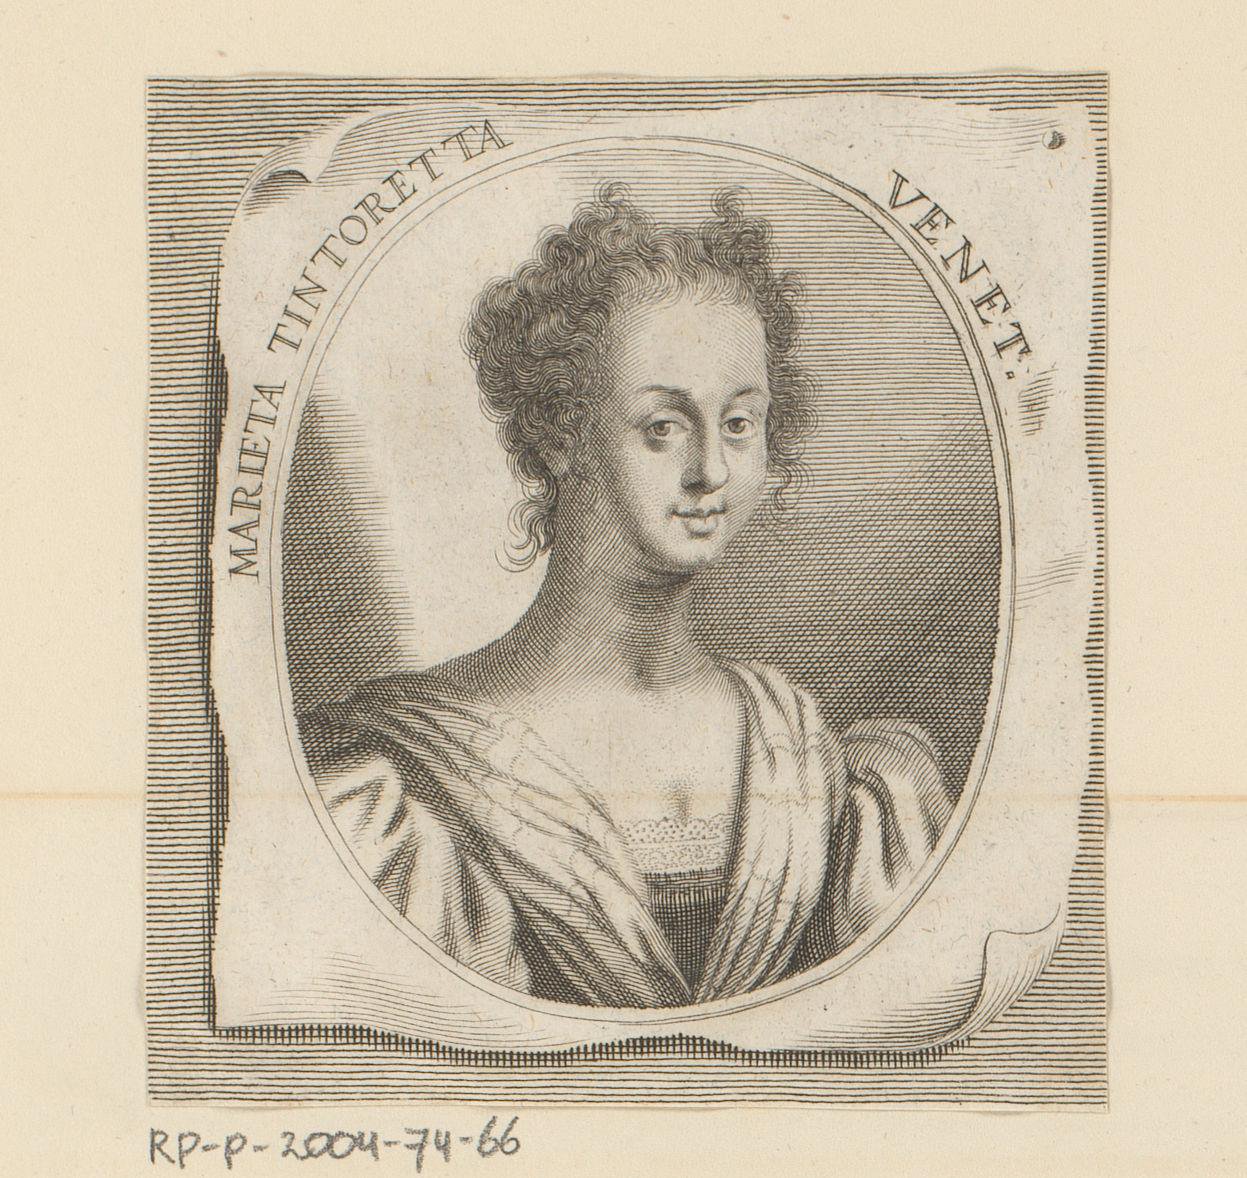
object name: album leaf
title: Portret van Marietta Robusti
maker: philipp kilian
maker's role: print maker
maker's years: 1628-1693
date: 1768-1775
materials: paper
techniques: engraving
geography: nuremberg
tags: marietta robusti, historical persons, portrait, self-portrait of painter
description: Prent uit: Sandrart, Joachim von. Teutsche Academie der Bau- Bildhauer- und Maler-Kunst: worinn die Regeln und Lehrsätze dieser Künste gegeben. 14 dln. Neurenberg: erven Johann Andreas Endter, [1774], dl. 7, p. R. De samensteller heeft deze prent in het album geplakt als illustratie bij: Pilkington, Matthew en Johann Heinrich Füssli. A dictionary of painters, from the revival of the art to the present period. 4 dln. Londen: John Crowder, 1805, dl. 3, p. 455.